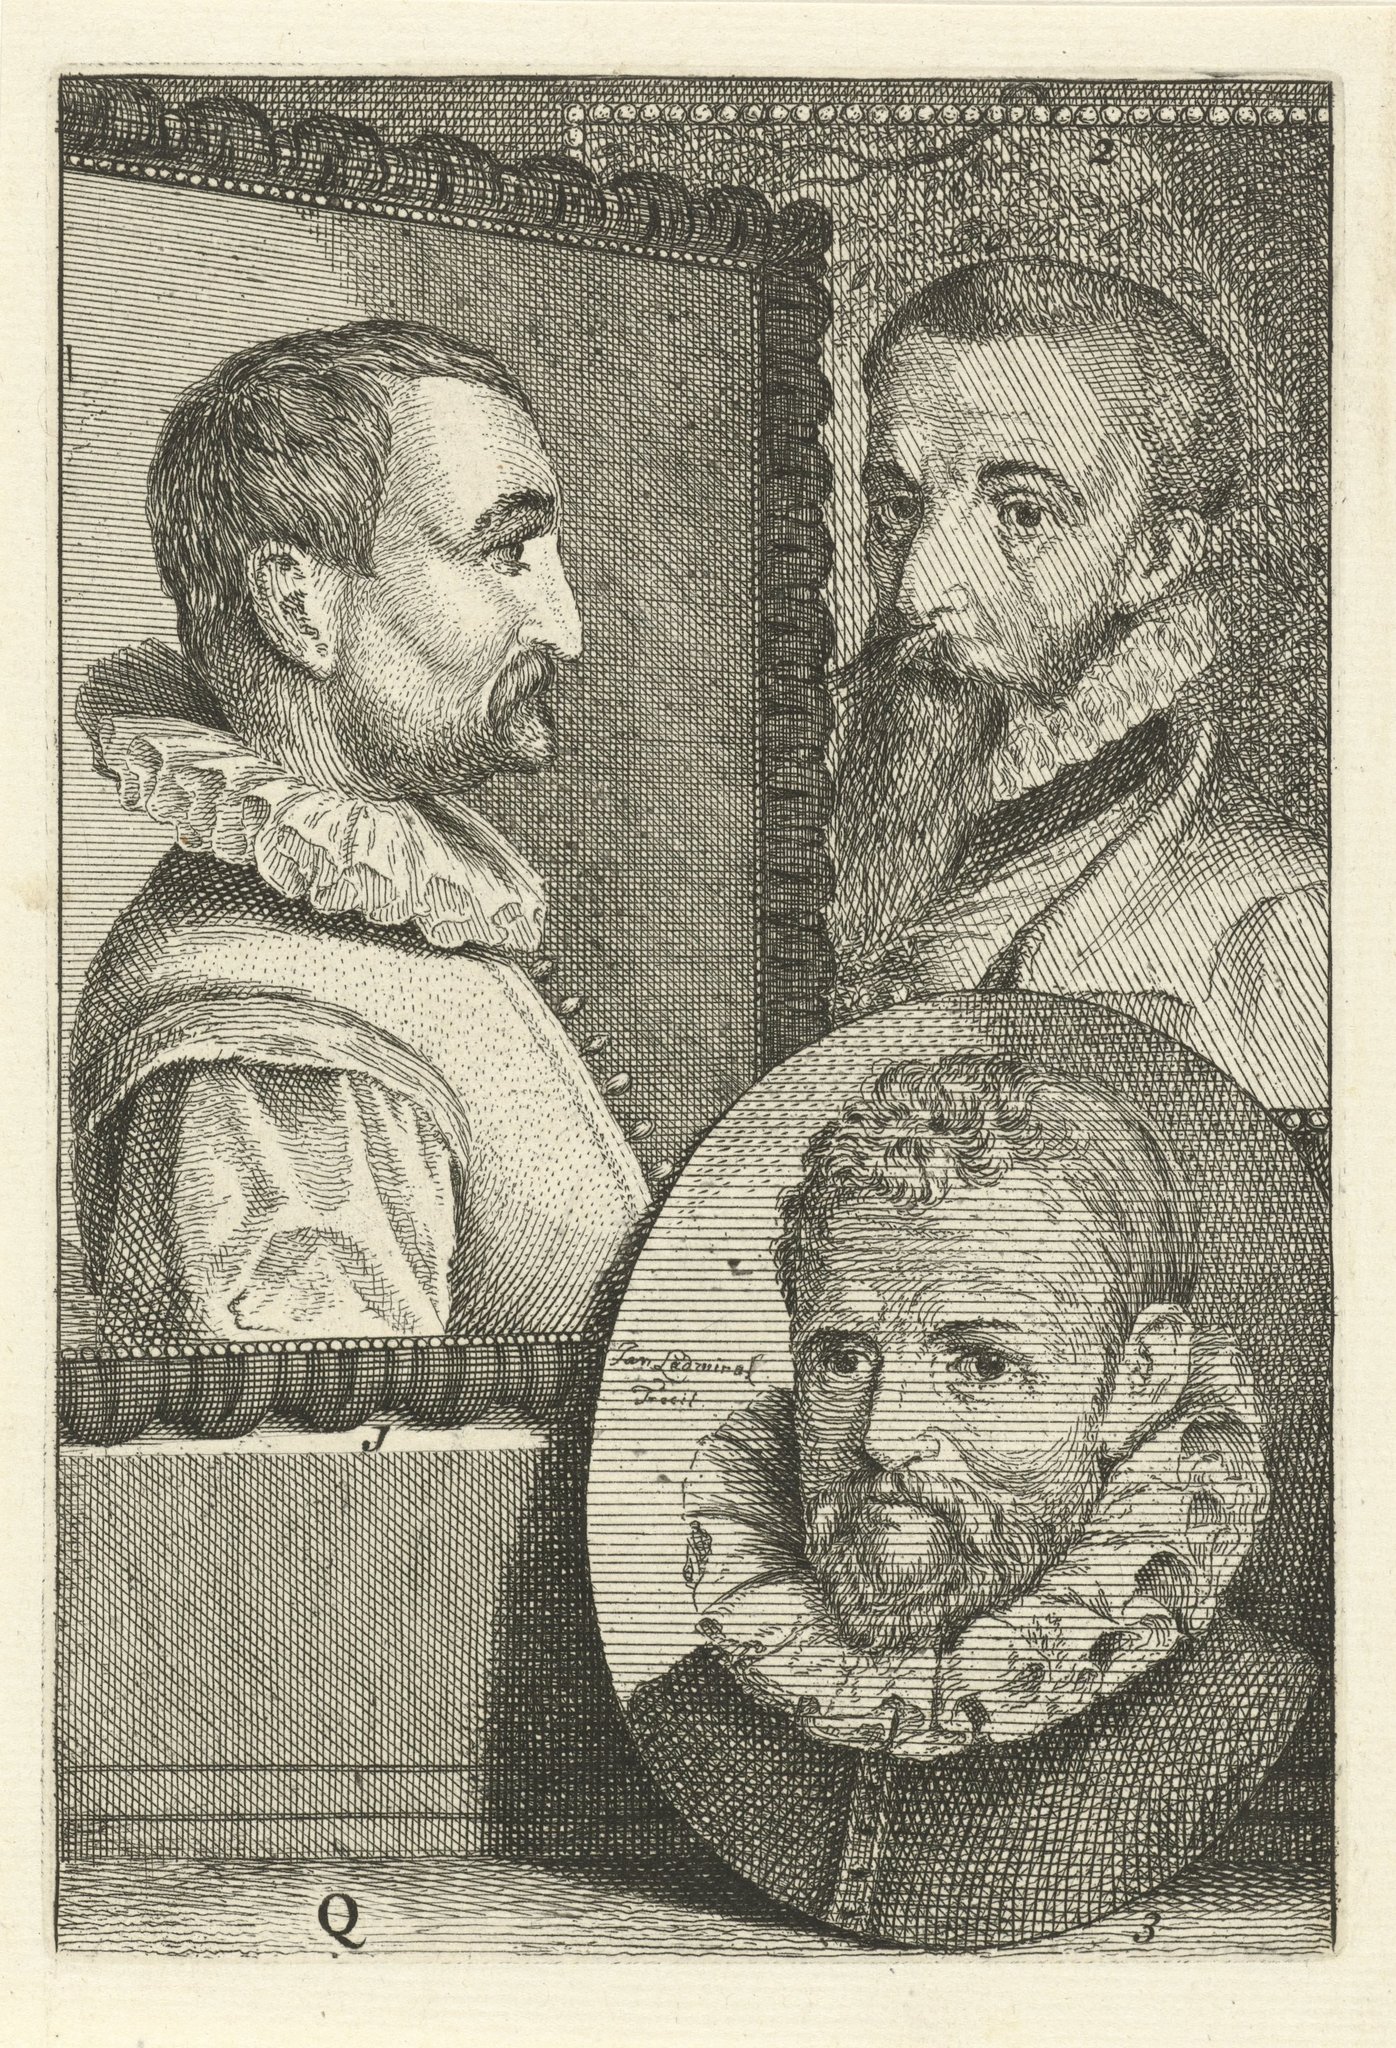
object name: book illustration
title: Portretten van Cornelis Visscher II, Christian van den Queborn en Gilles Mostaert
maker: jan l admiral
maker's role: draughtsman, print maker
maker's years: 1699-1773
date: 1764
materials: paper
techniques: etching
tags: gilles mostaert, haarlem, draughtsman, cornelis visscher (ii), antwerp, painter, christian van den queborn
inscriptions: collector's mark: Lugt 2228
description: Prent opgenomen in: Mander, Karel van; Jongh, Jacobus de (vert.). Het leven der doorluchtige Nederlandsche en eenige Hoogduitsche schilders. Amsterdam: Steven van Esveldt, 1764.